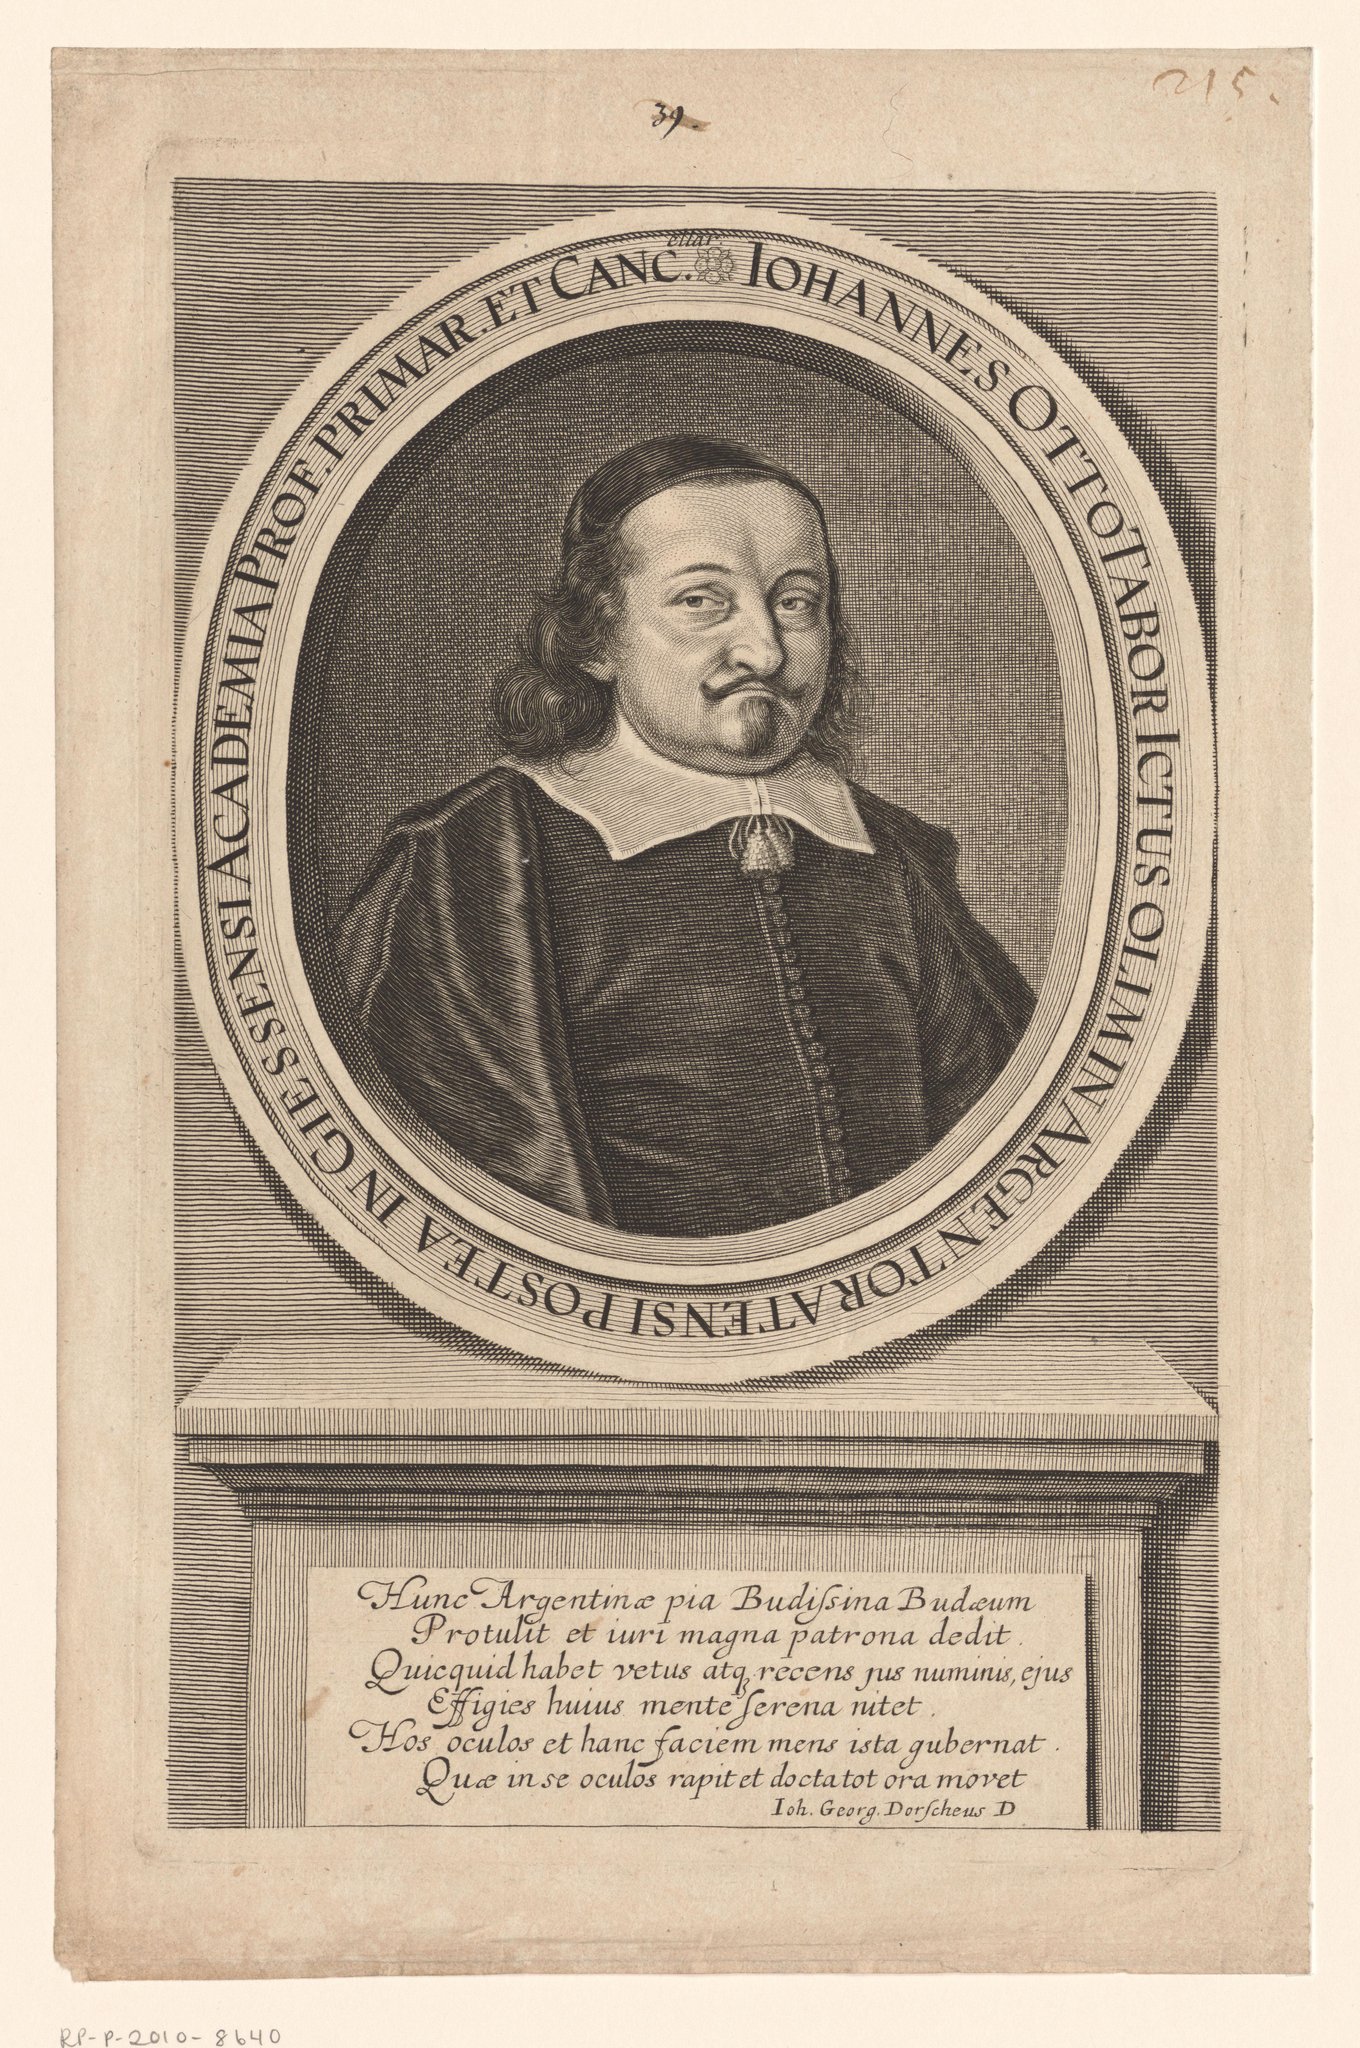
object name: print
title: Portret van Johann Otto Tabor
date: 1659-1699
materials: paper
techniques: engraving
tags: historical persons, professor